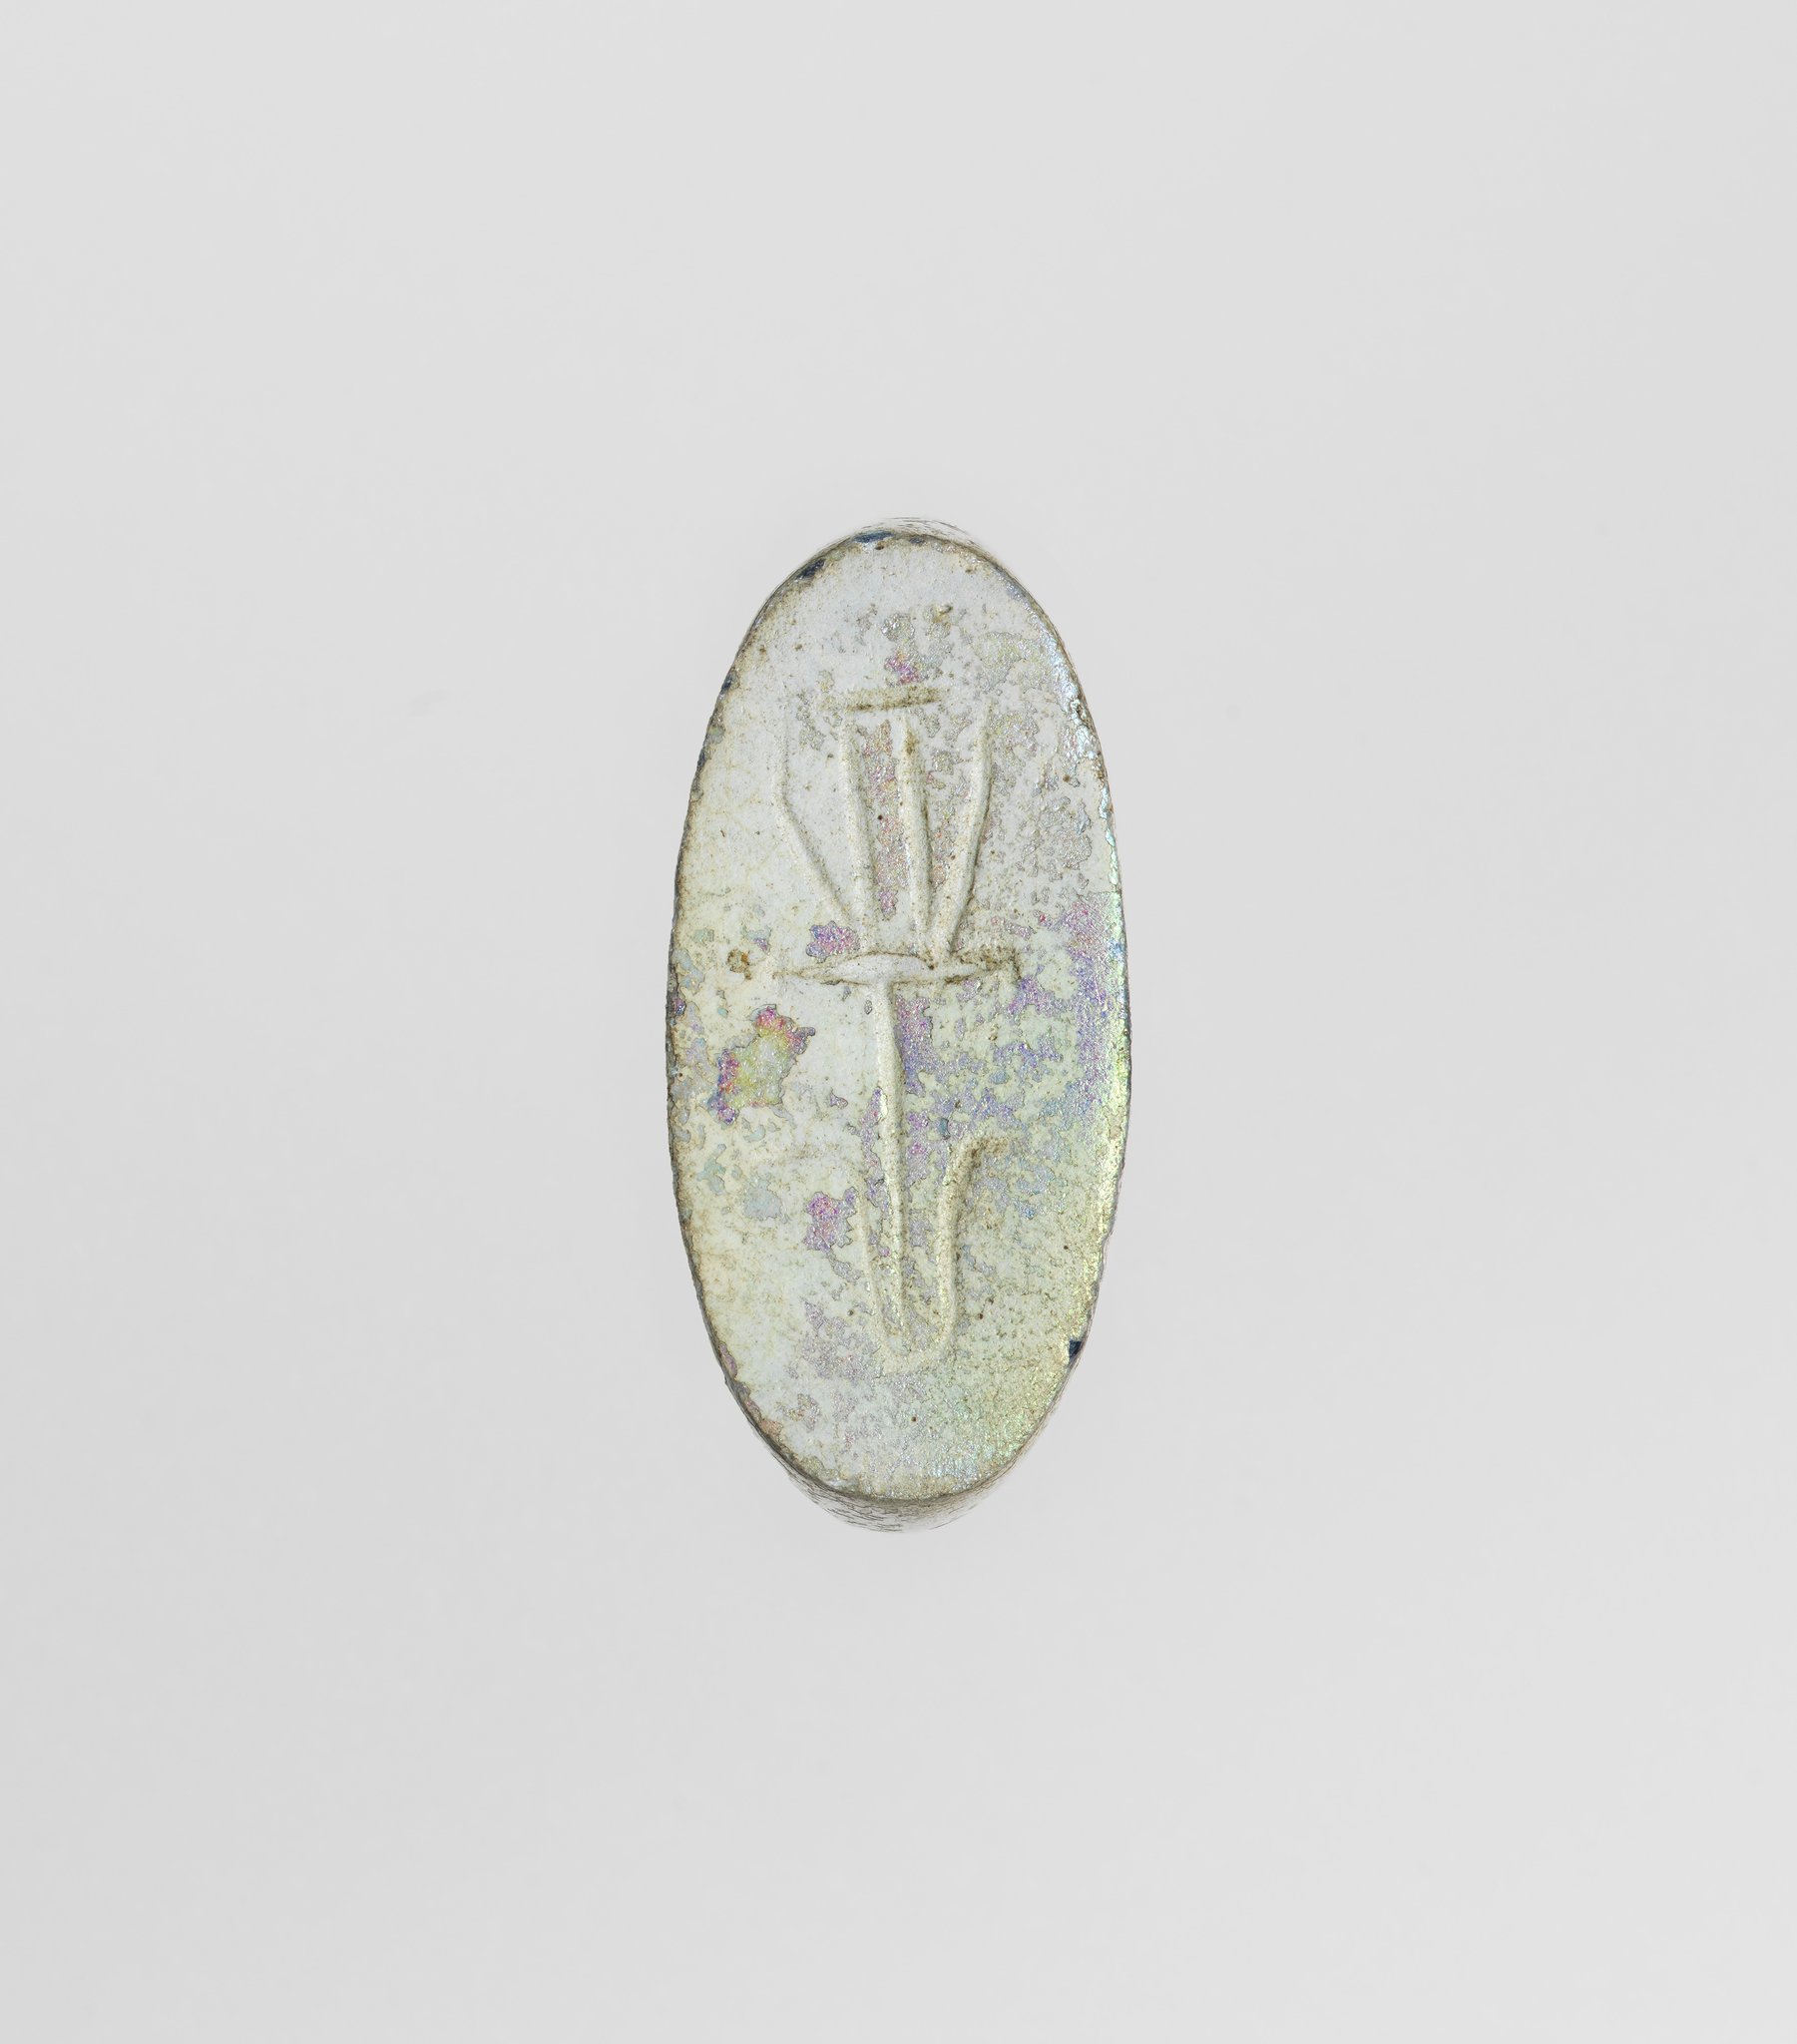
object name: ring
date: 1070-712 BCE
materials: glass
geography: egypt